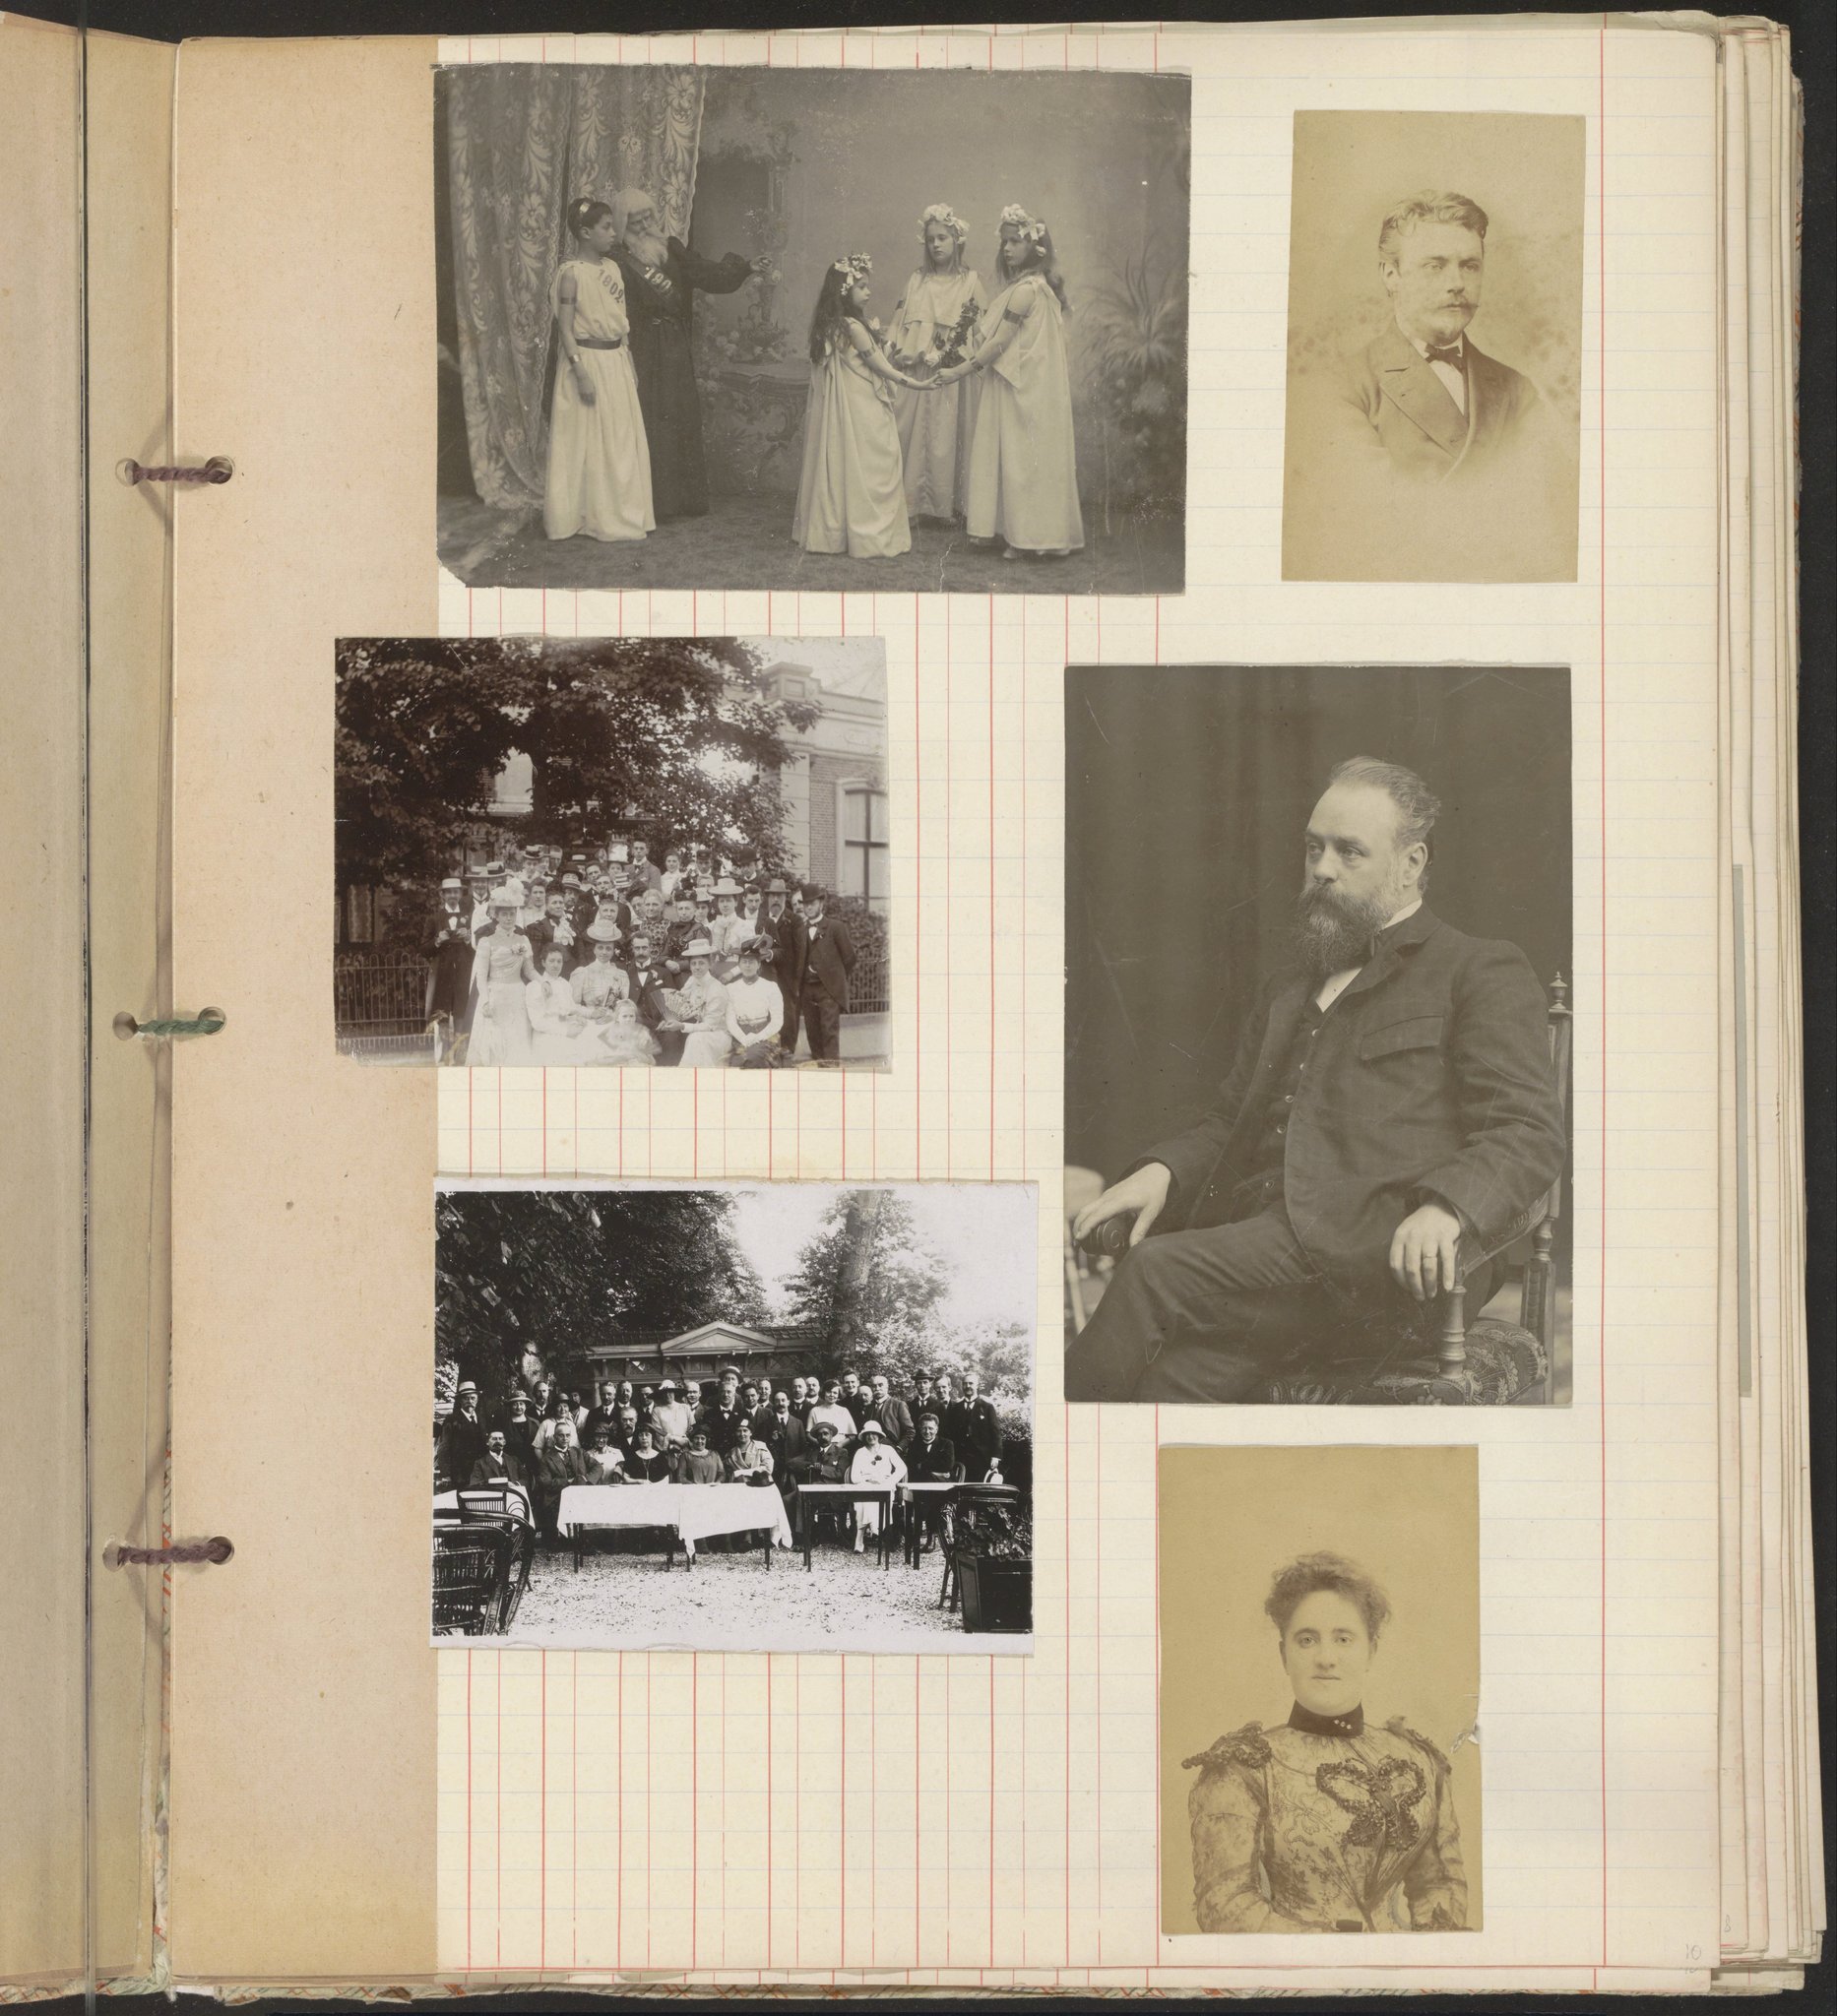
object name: album leaf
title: Portretten van onbekende personen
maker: Anonymous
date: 1901-1907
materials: paper, photographic support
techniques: albumen print, gelatin silver print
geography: netherlands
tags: utrecht, adult woman, adult man, child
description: Albumblad met een portretten en groepsportretten van volwassenen. Linksboven een opname van verklede kinderen met een oude man, de personificatie van de jaarwisseling 1901/1902. Midden rechts een portret van (vermoedelijk) Martinus W. Petri, zittend. Onderdeel van Fotoalbum van de familie Petri.